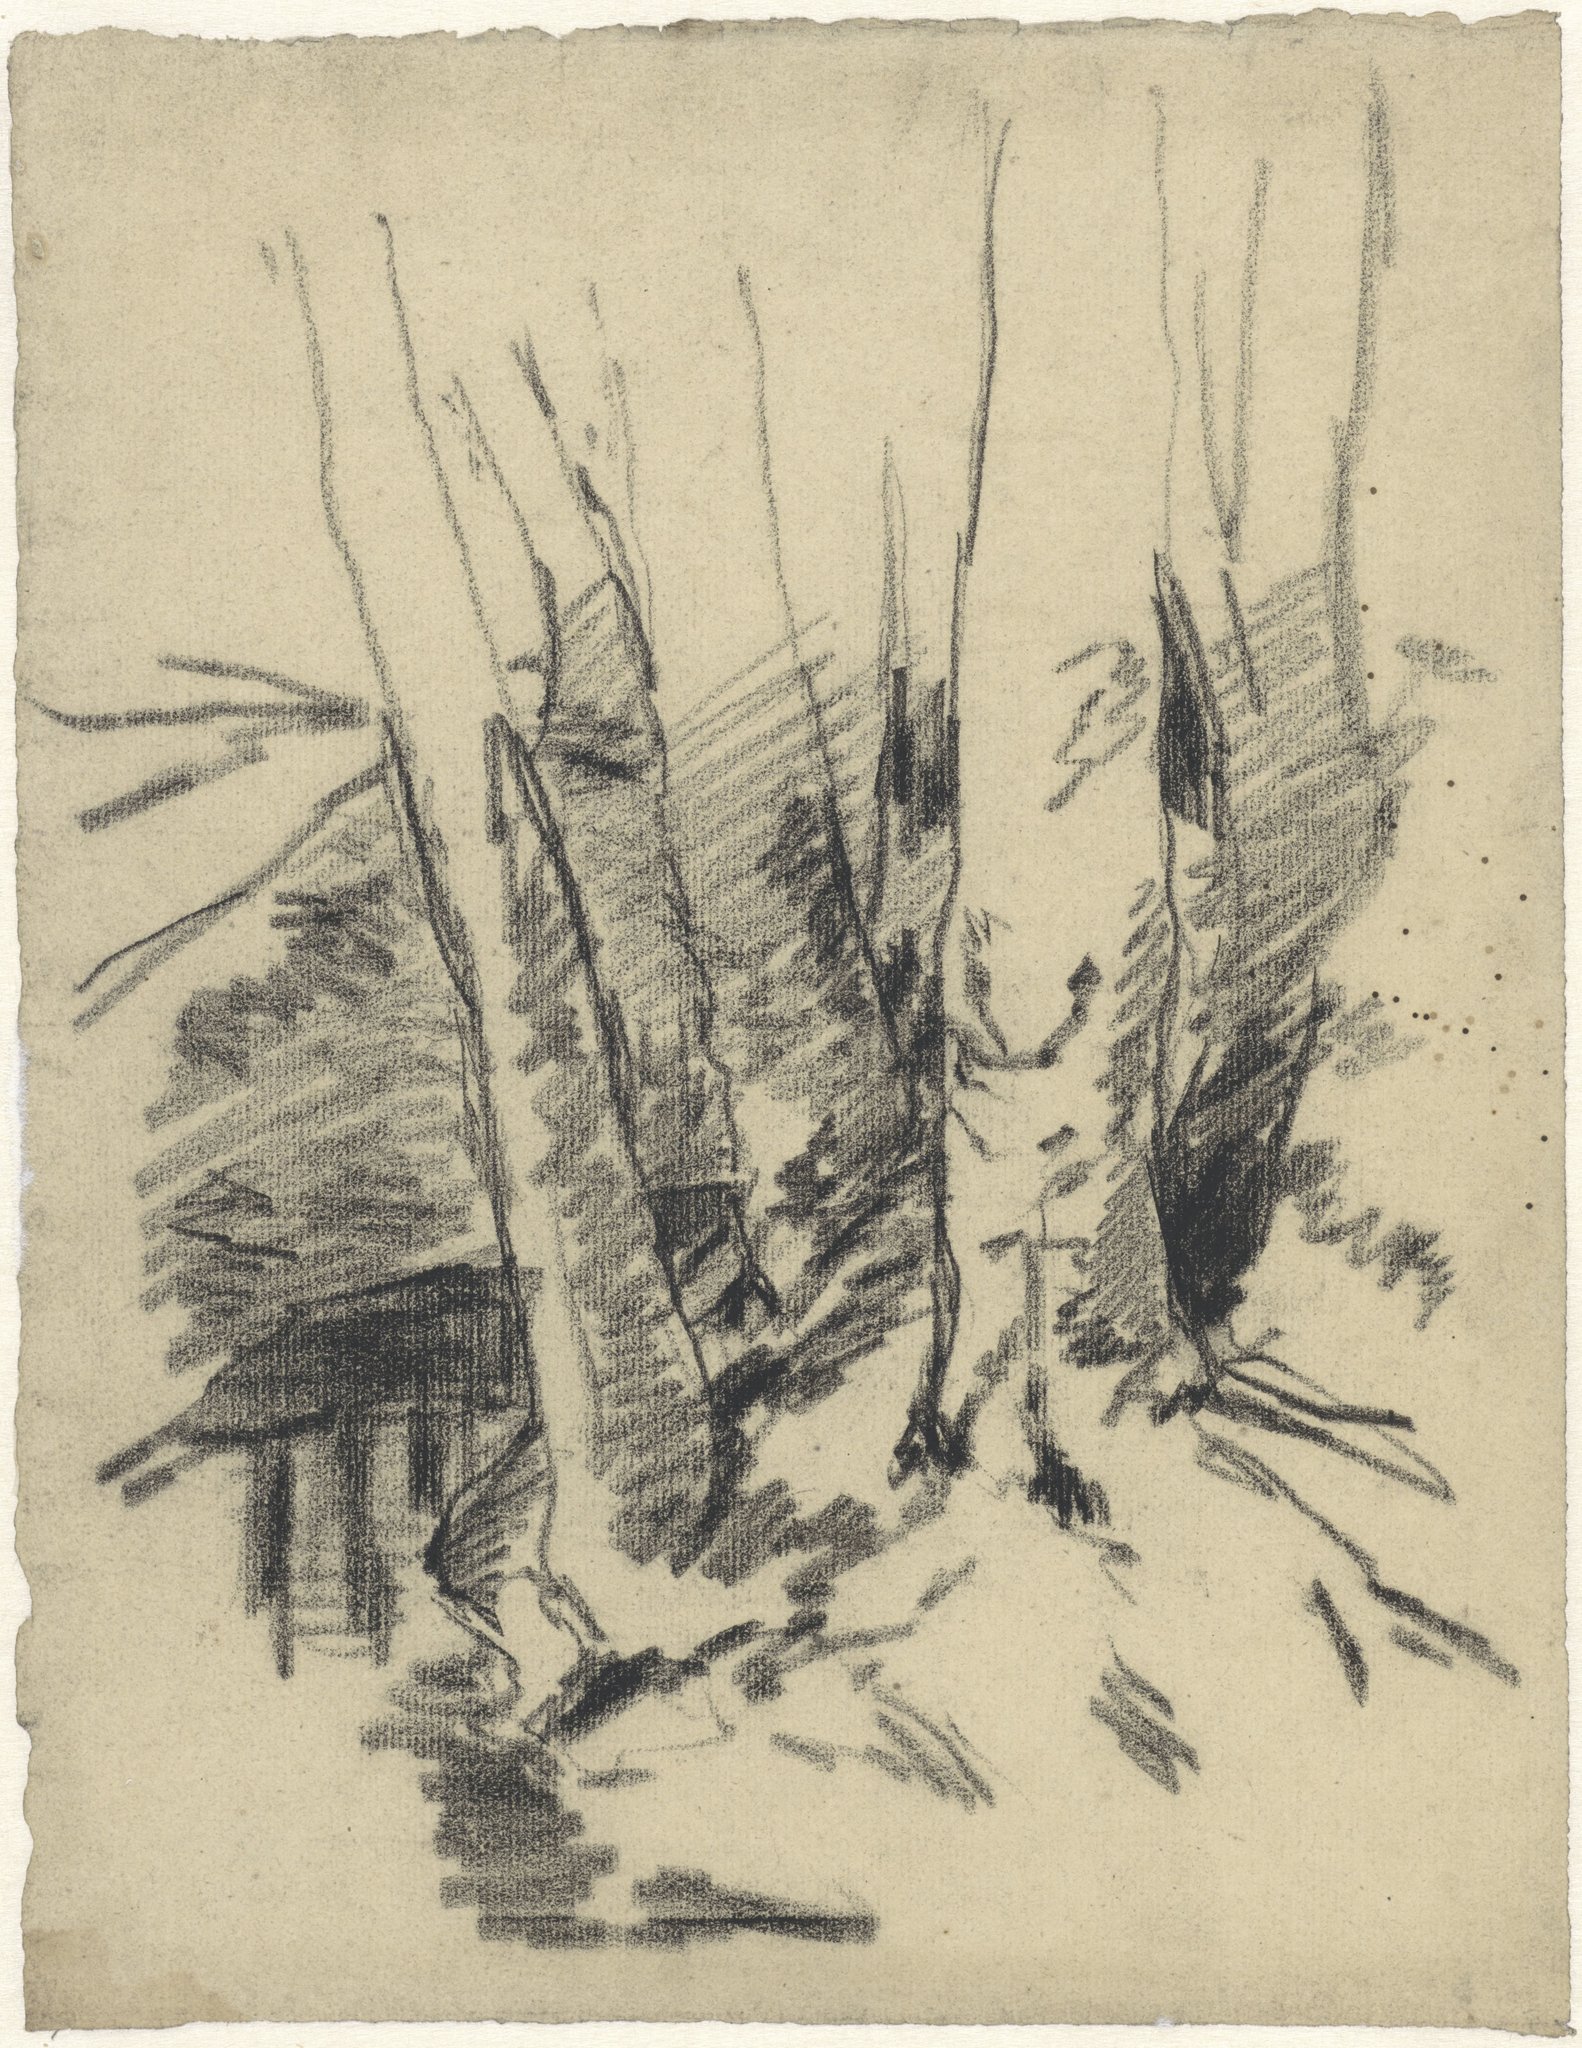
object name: drawing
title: Studie van vier boomstammen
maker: egbert rubertus derk schaap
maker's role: draughtsman, painter, print maker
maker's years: 1862-1939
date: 1872-1939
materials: chalk, paper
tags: trees